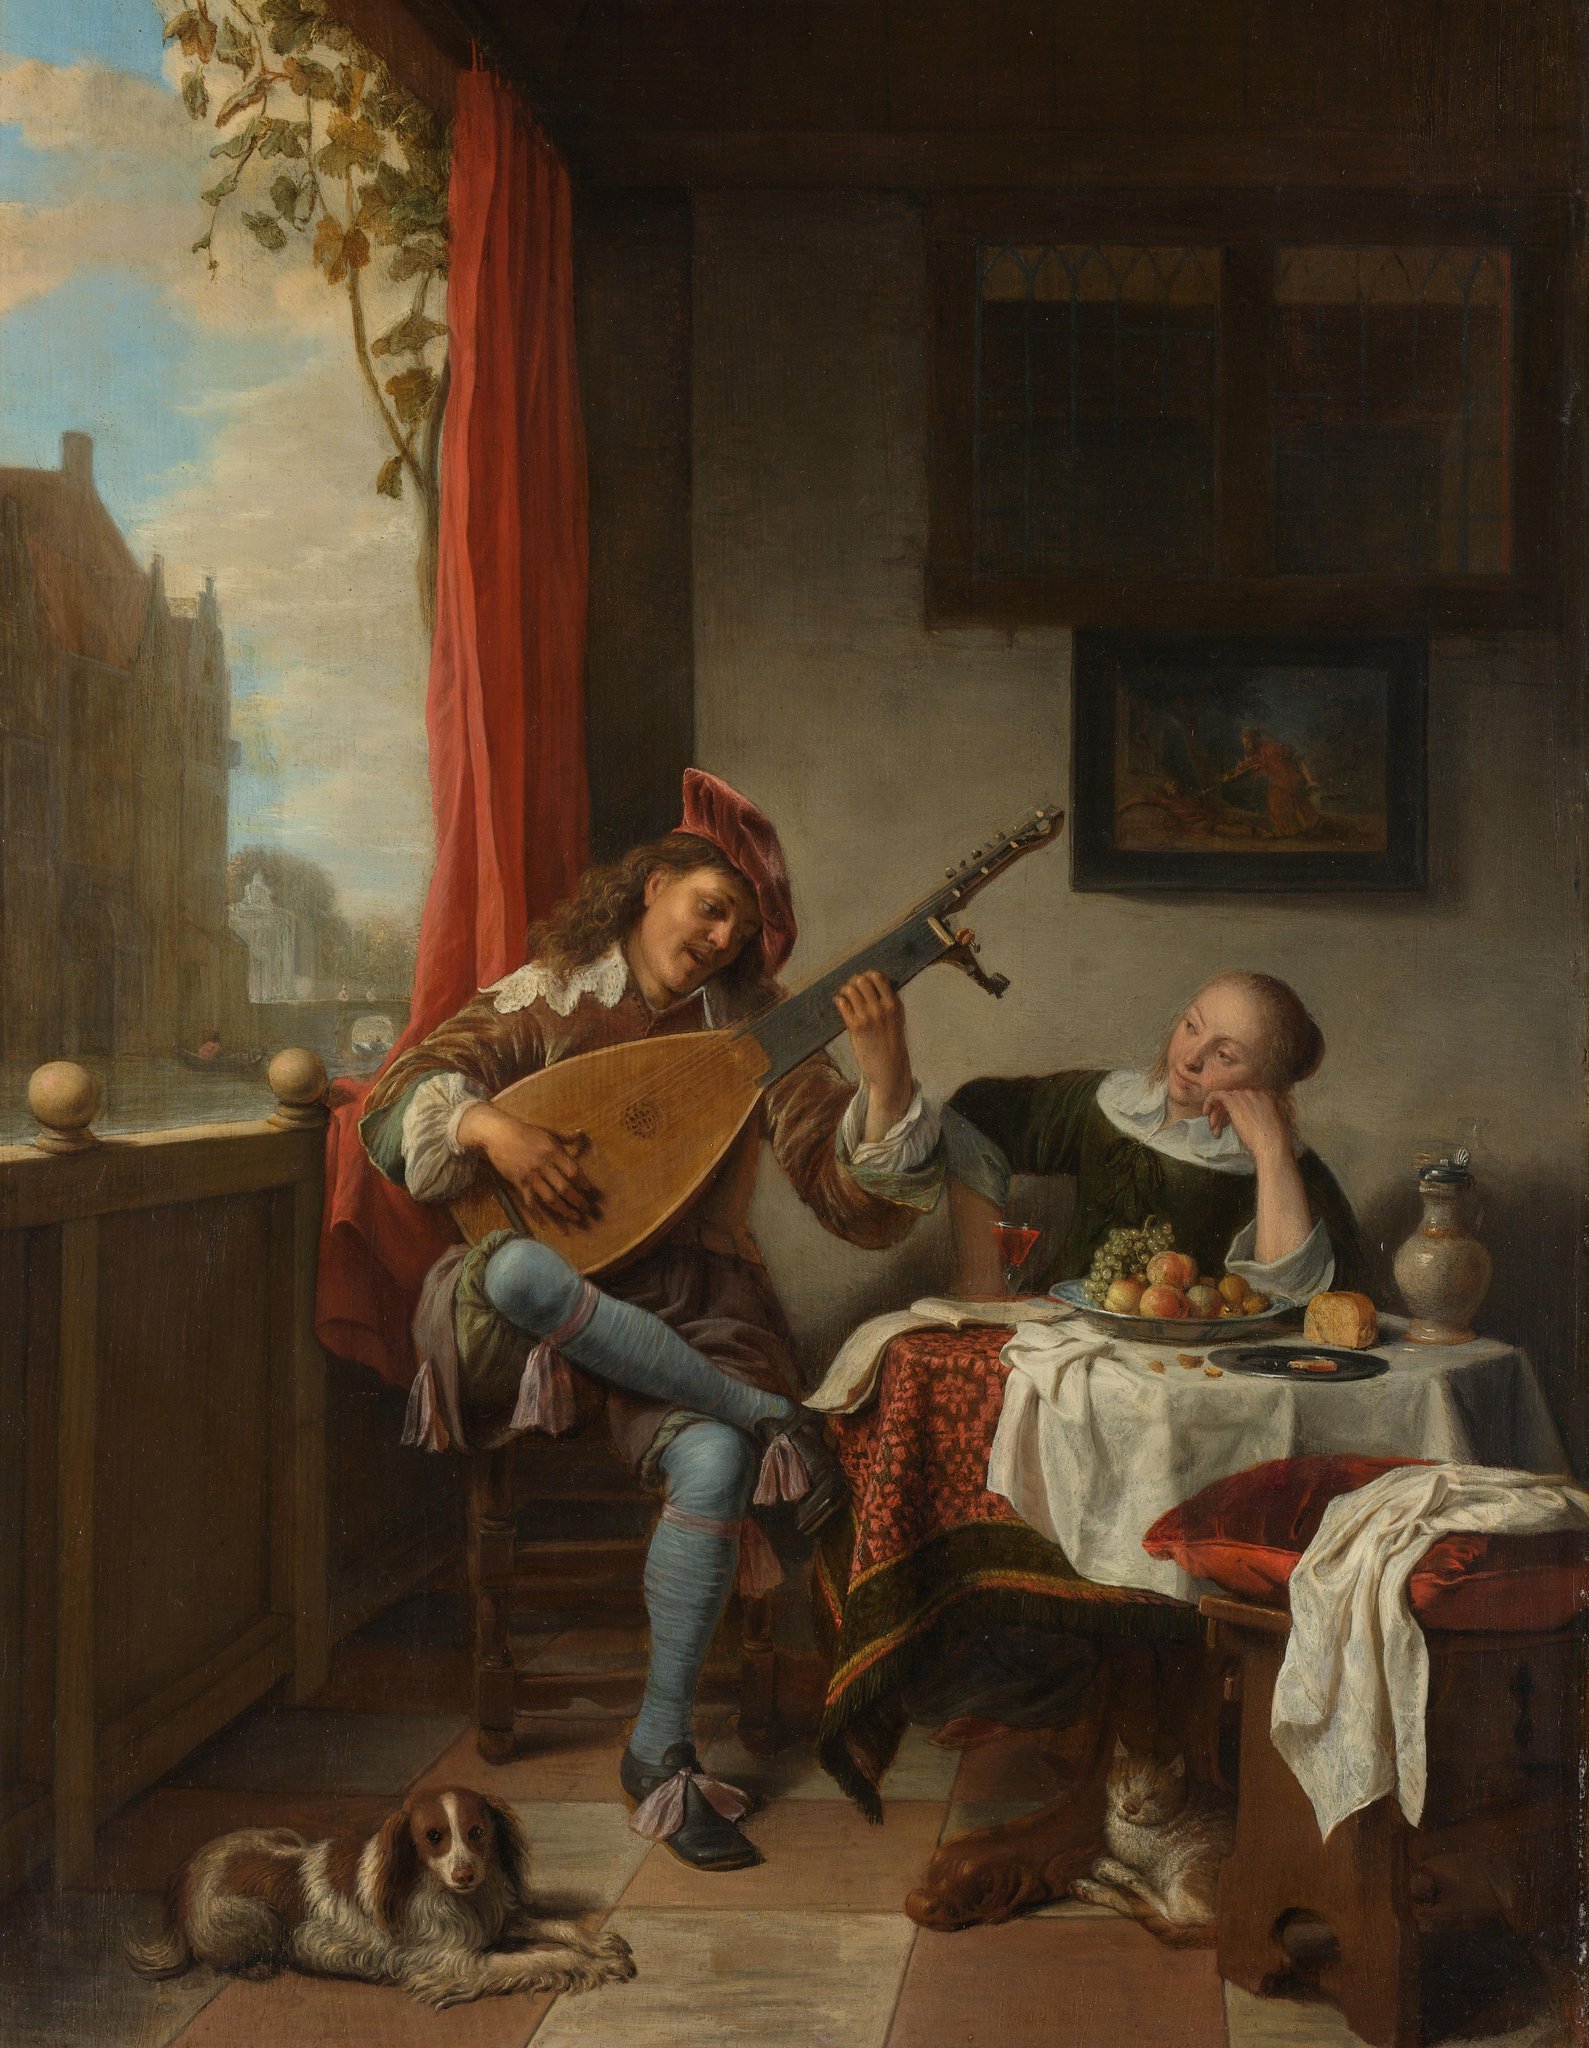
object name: painting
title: Lute Player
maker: hendrick martensz. sorgh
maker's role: draughtsman, painter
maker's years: 1609-1670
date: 1661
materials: oil, panel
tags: one person playing string instrument (plucked), lute, and special forms of lute, e.g.: theorbo, dog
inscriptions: signature and date: ‘M. Sorgh. 1661’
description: A young man is singing and playing the lute on an open veranda. Where the woman’s thoughts have wandered is a mystery. The music and the theme of the paramours Pyramus and Thisbe in the painting in the background suggest that harmonious love is the subject. Yet the work may also be a warning against impulsive lust. Both interpretations are equally valid.